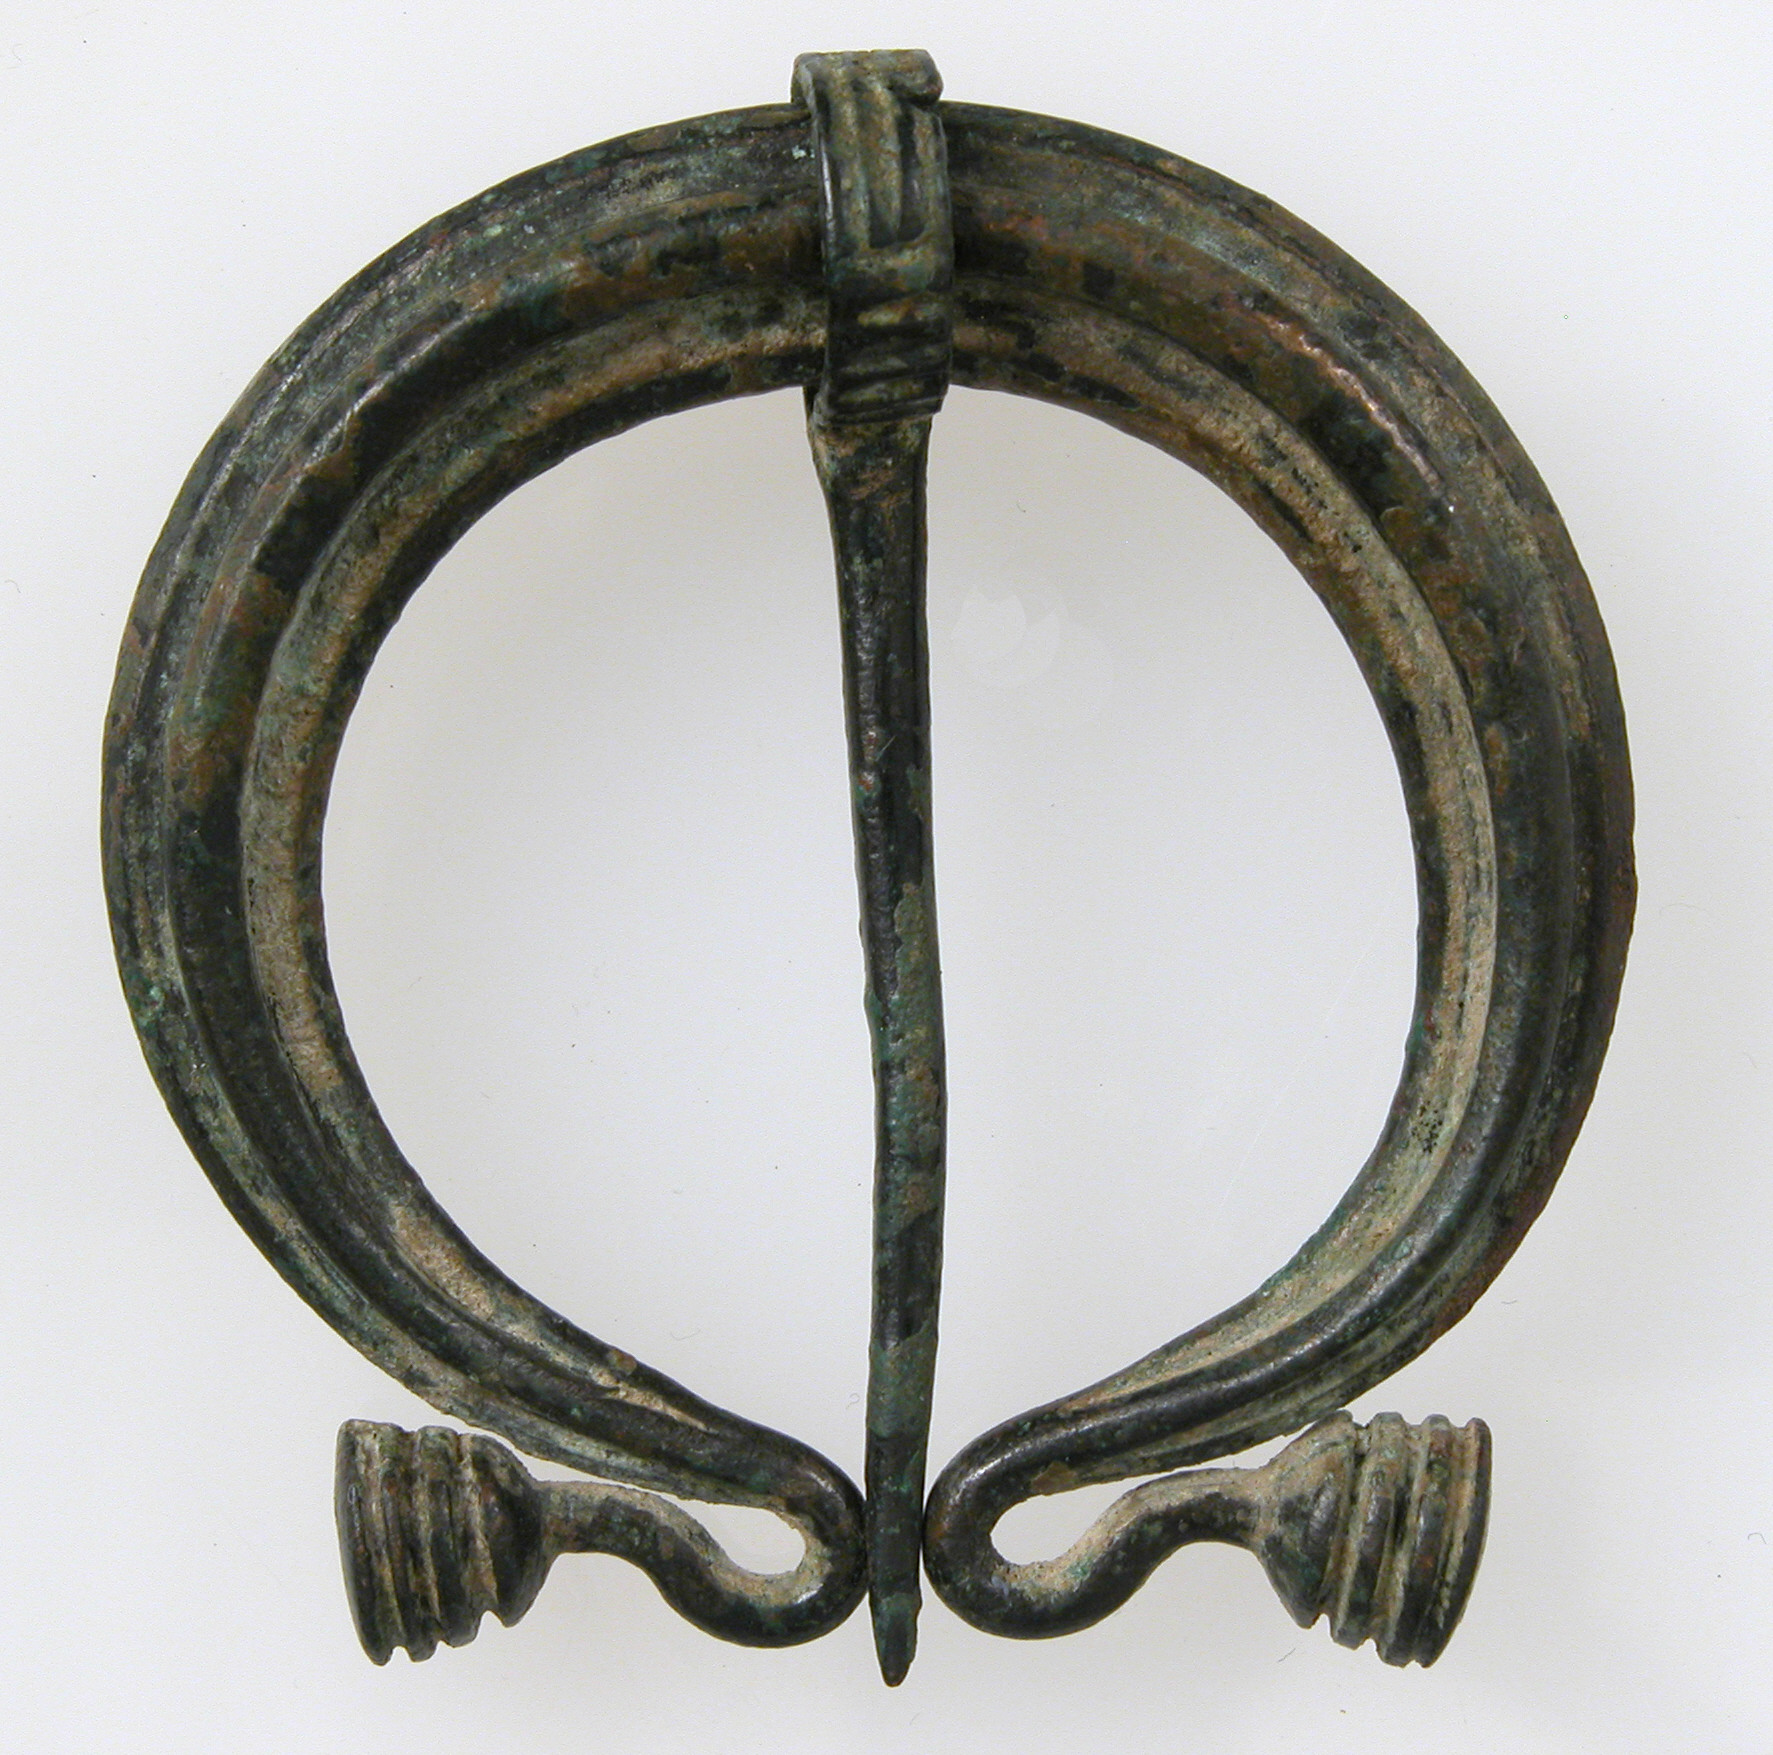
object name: brooch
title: Pennanular or Omega Brooch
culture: roman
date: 1-200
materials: bronze